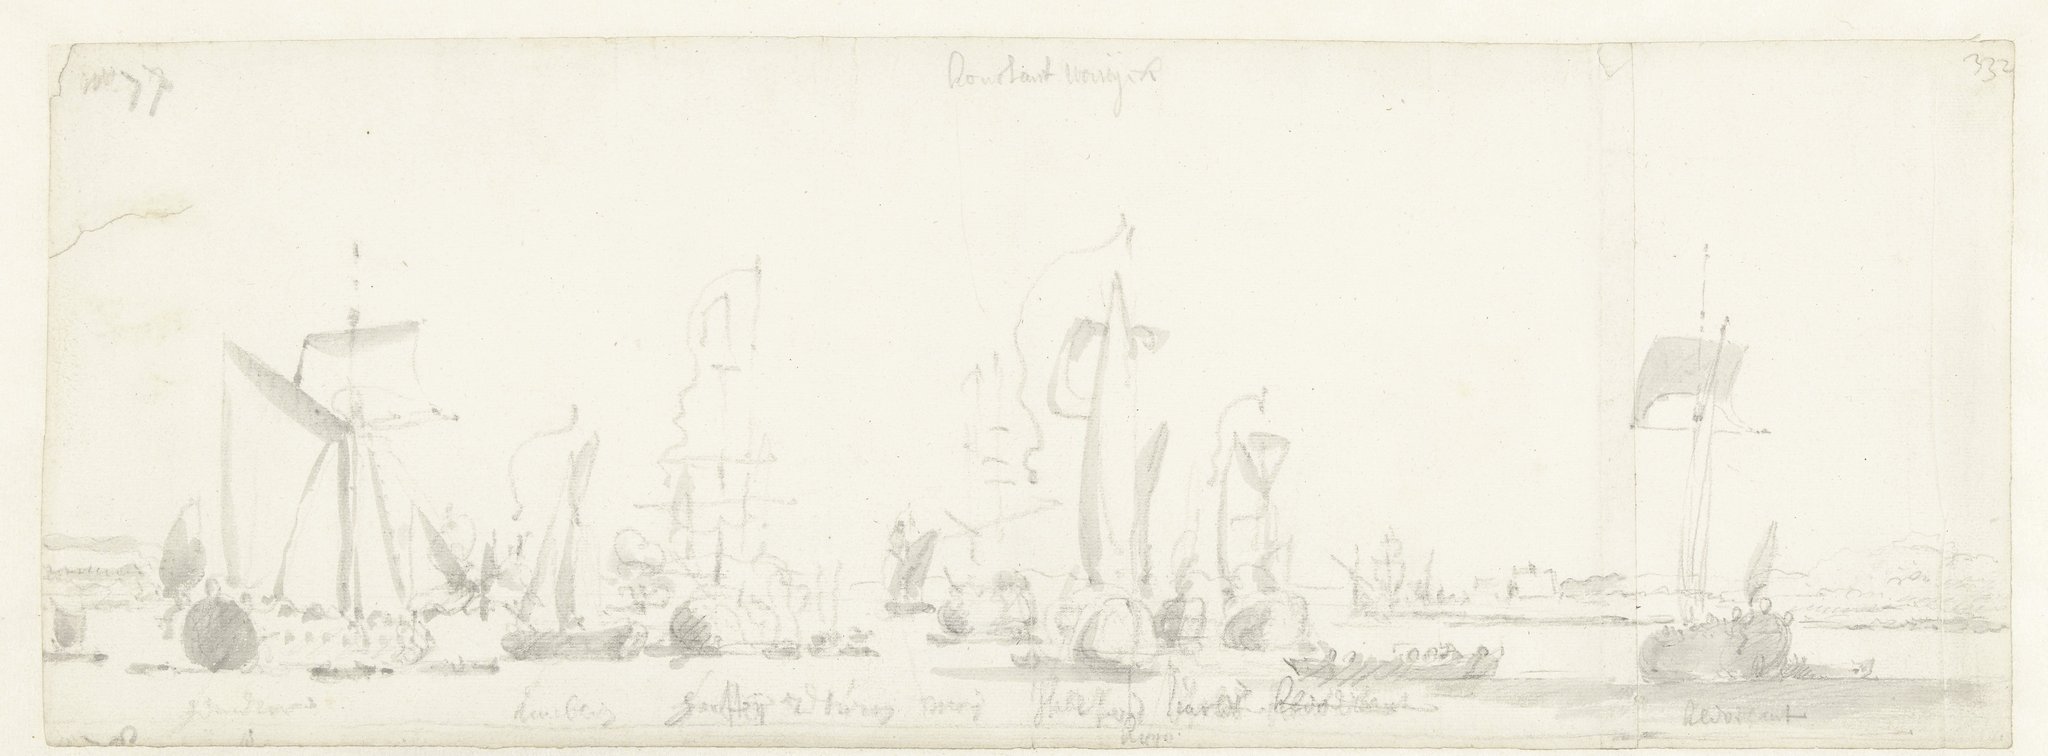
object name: drawing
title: De tocht van de Engelse koning Karel II over de Thames naar Sheerness en Chatham op 27 Augustus 1681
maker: willem van de velde (i)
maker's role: draughtsman, painter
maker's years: 1611-1693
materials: chalk, paper, pencil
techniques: brush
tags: london, karel ii (koning van engeland), names of artefacts and man-made objects (buildings excluded), river, visiting; receiving guests; elegant company, sailing-ship, sailing-boat (with name), thames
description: De tocht van de Engelse koning Karel II over de Thames naar Sheerness en Chatham op 27 augustus 1681. Hier de vloot van jachten rondom het schip Constant Warwick, waaronder Charlotte, Cleveland, Henrietta, Isabella, Kitchen en Mary.